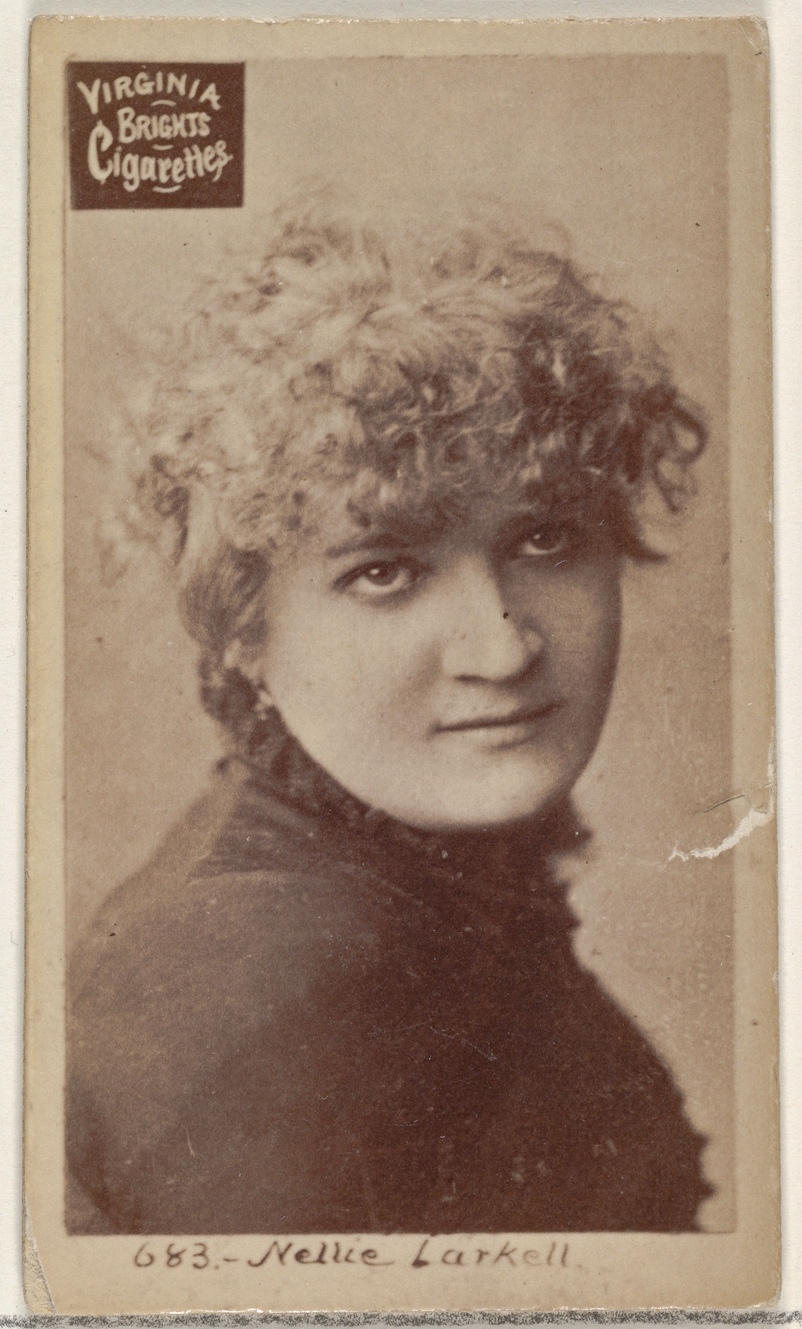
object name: photograph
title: Card 683, Nellie Larkell, from the Actors and Actresses series (N45, Type 2) for Virginia Brights Cigarettes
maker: allen & ginter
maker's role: publisher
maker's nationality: american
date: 1888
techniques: albumen silver print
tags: portraits,women,actresses